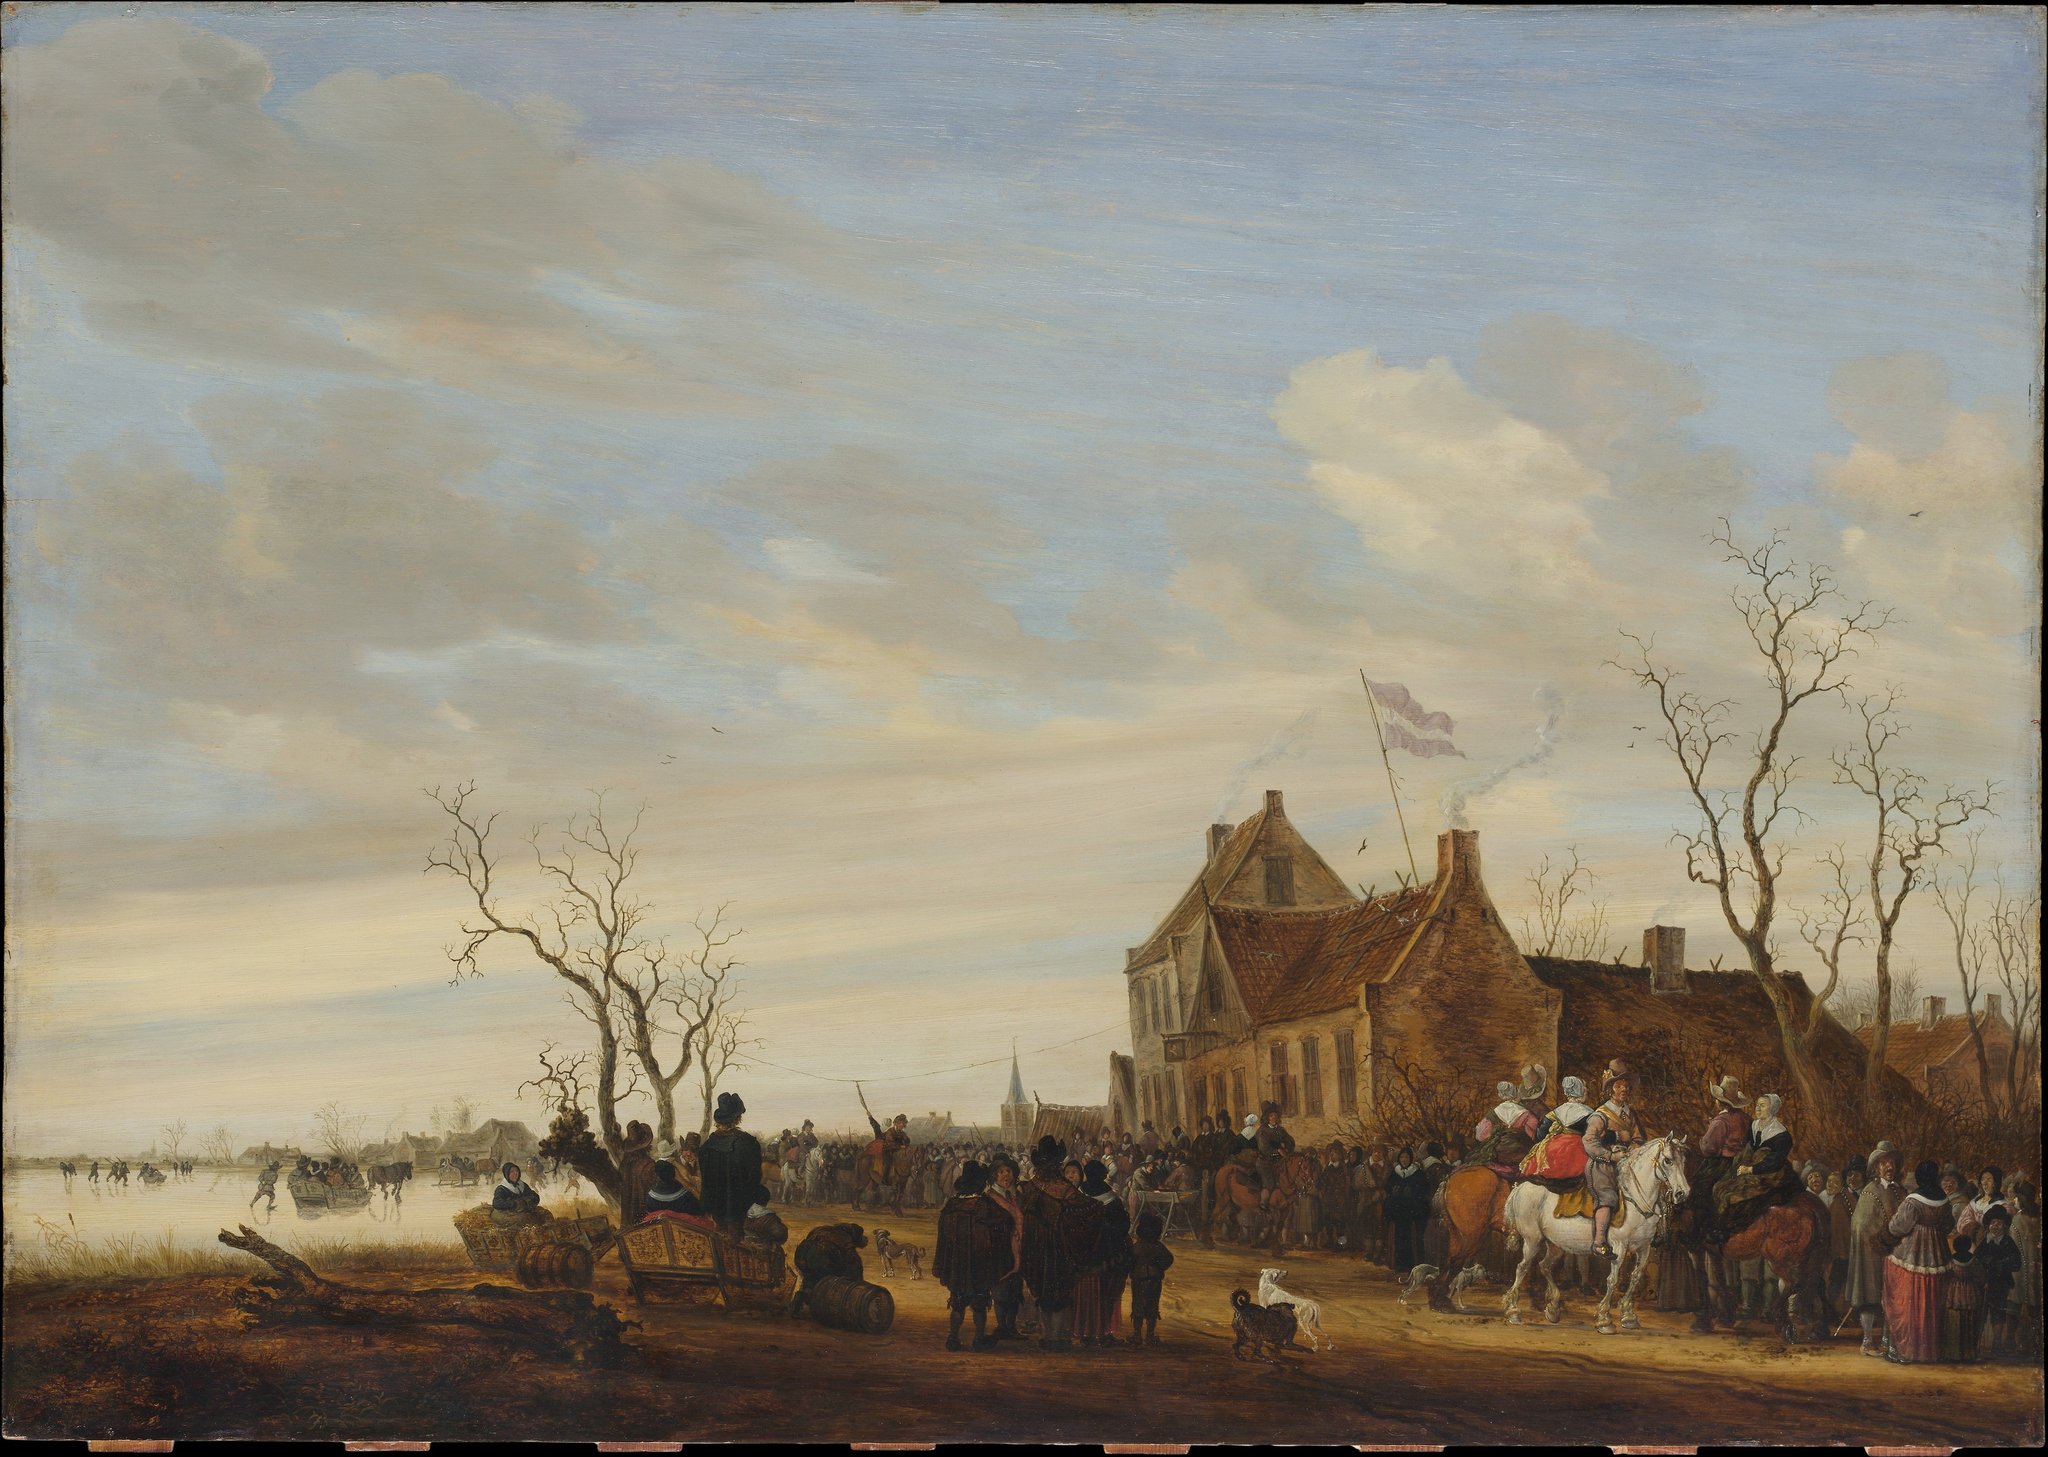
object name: painting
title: Drawing the Eel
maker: salomon van ruysdael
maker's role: artist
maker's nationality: dutch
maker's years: 1600-1670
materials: oil, wood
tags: villages,men,women,horses,winter